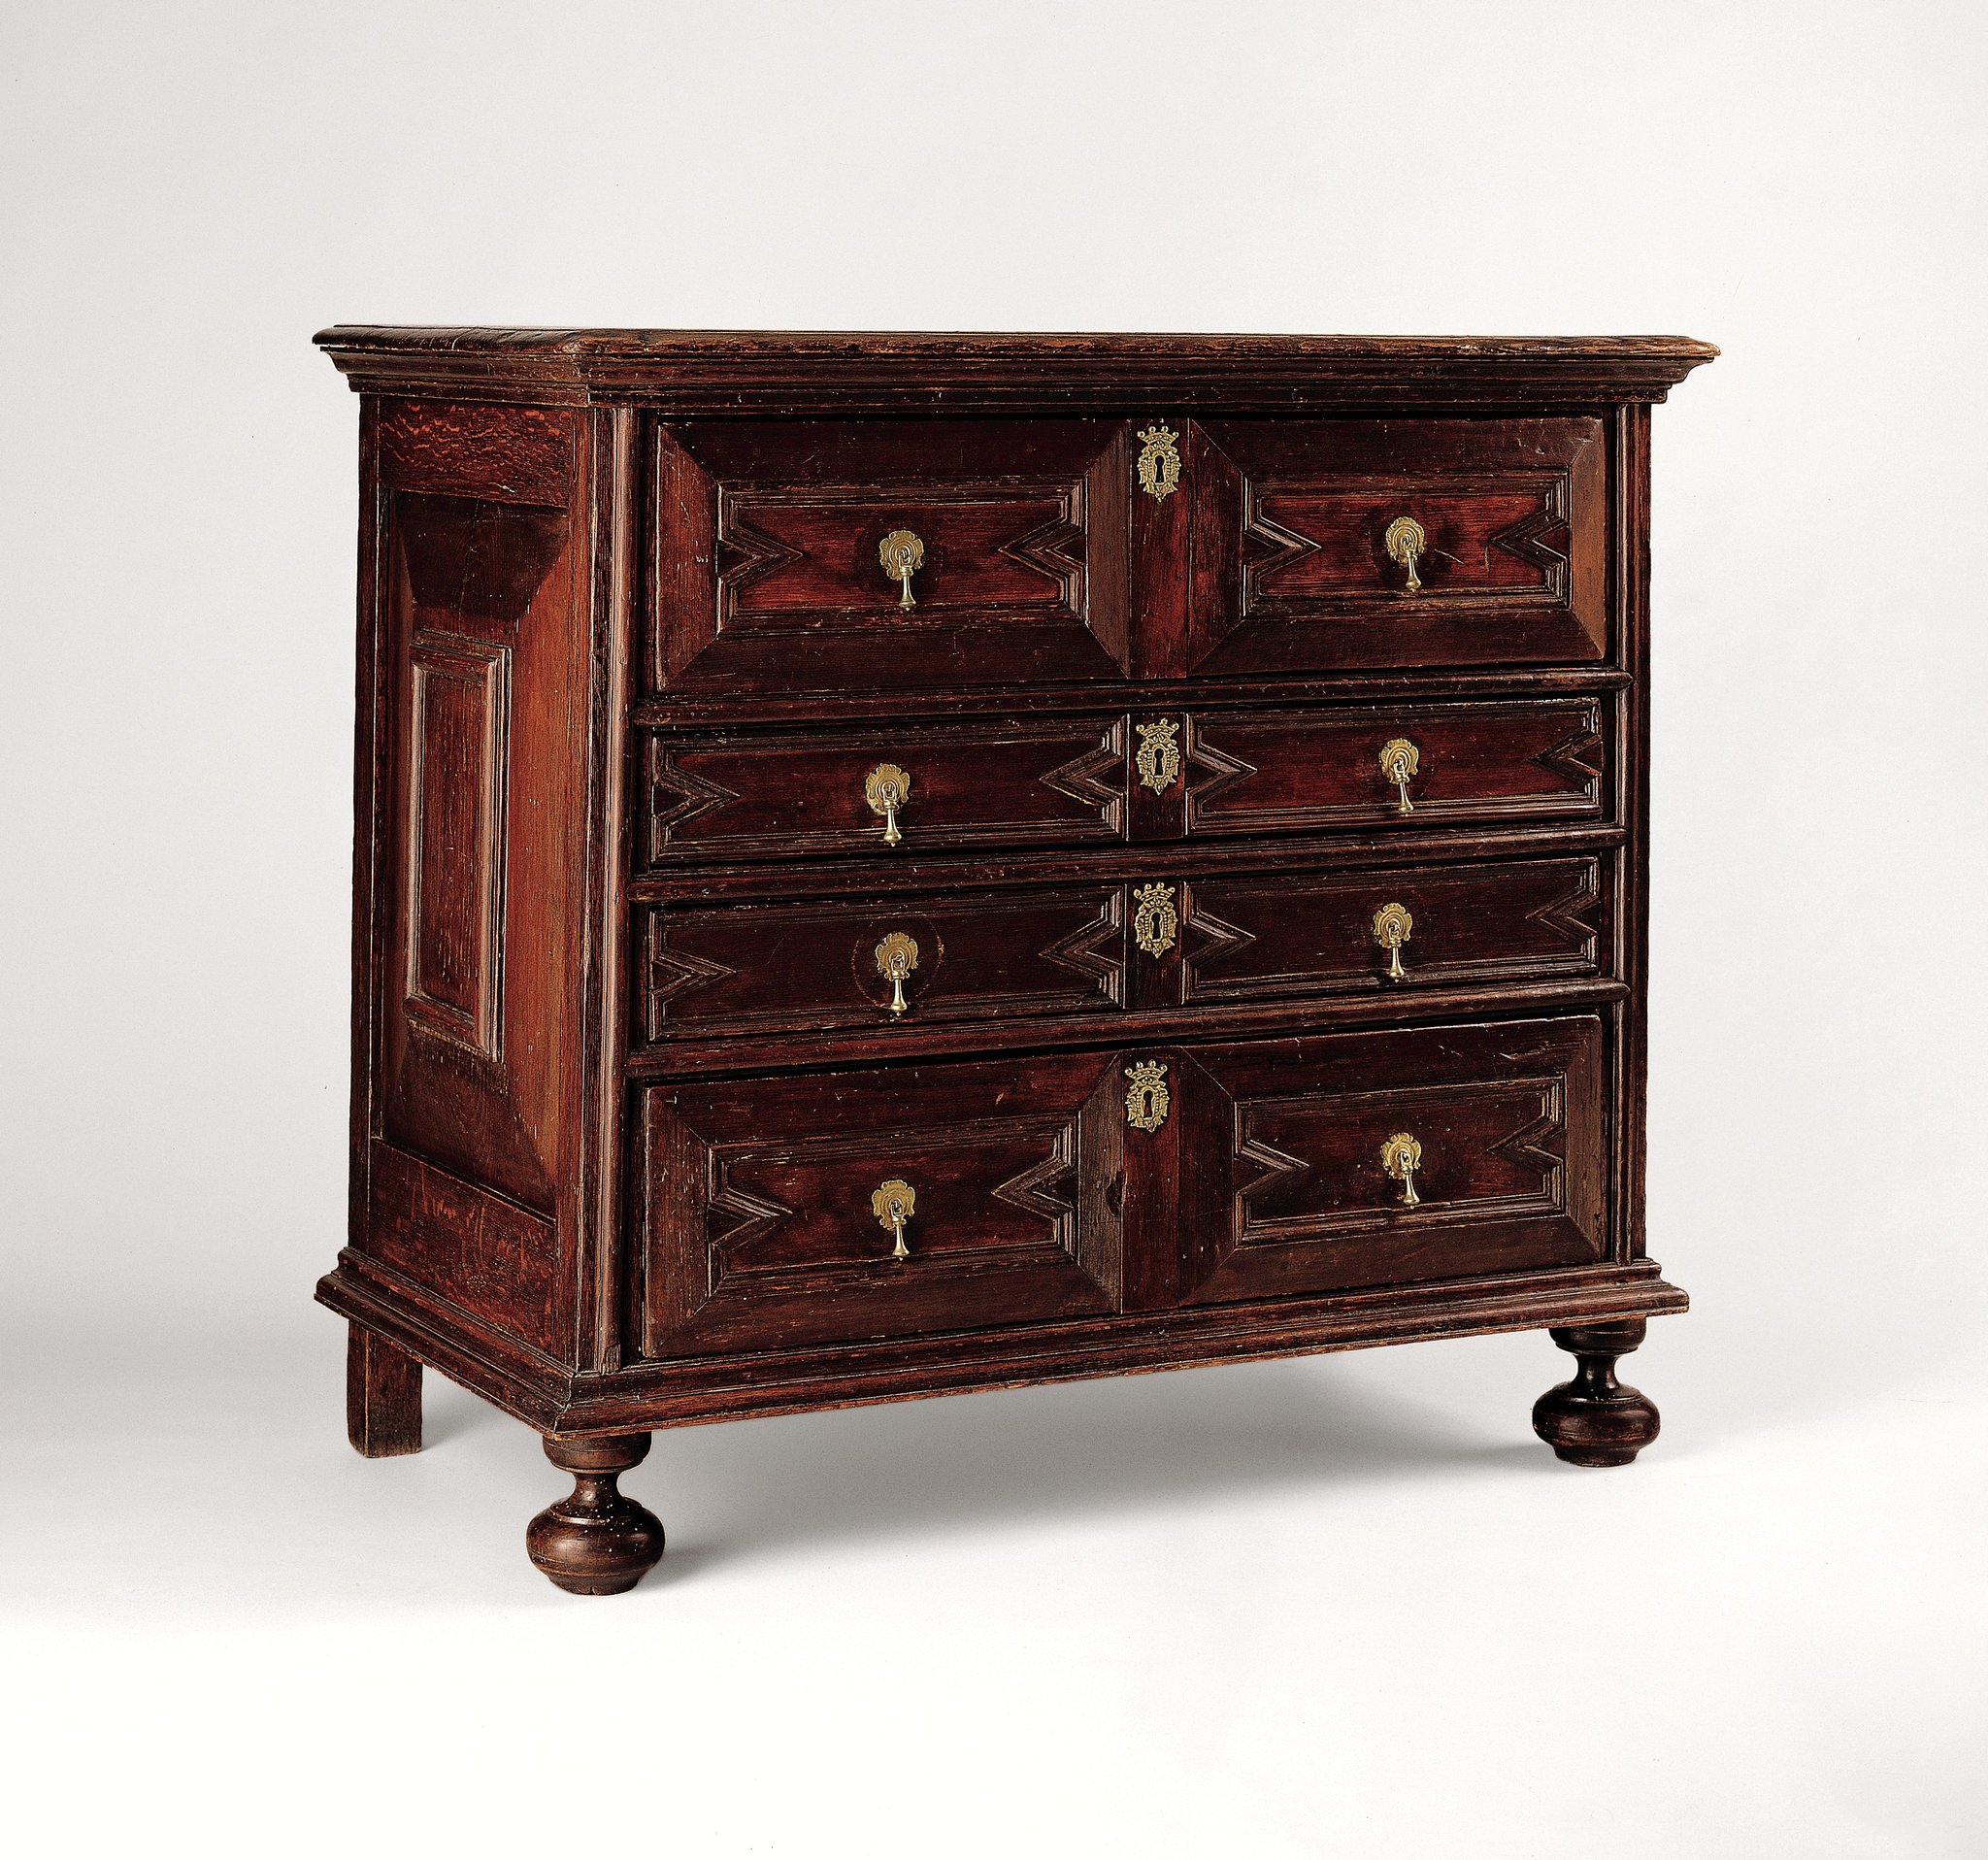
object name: chest of drawer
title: Chest of Drawers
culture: american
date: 1700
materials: wood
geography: united states